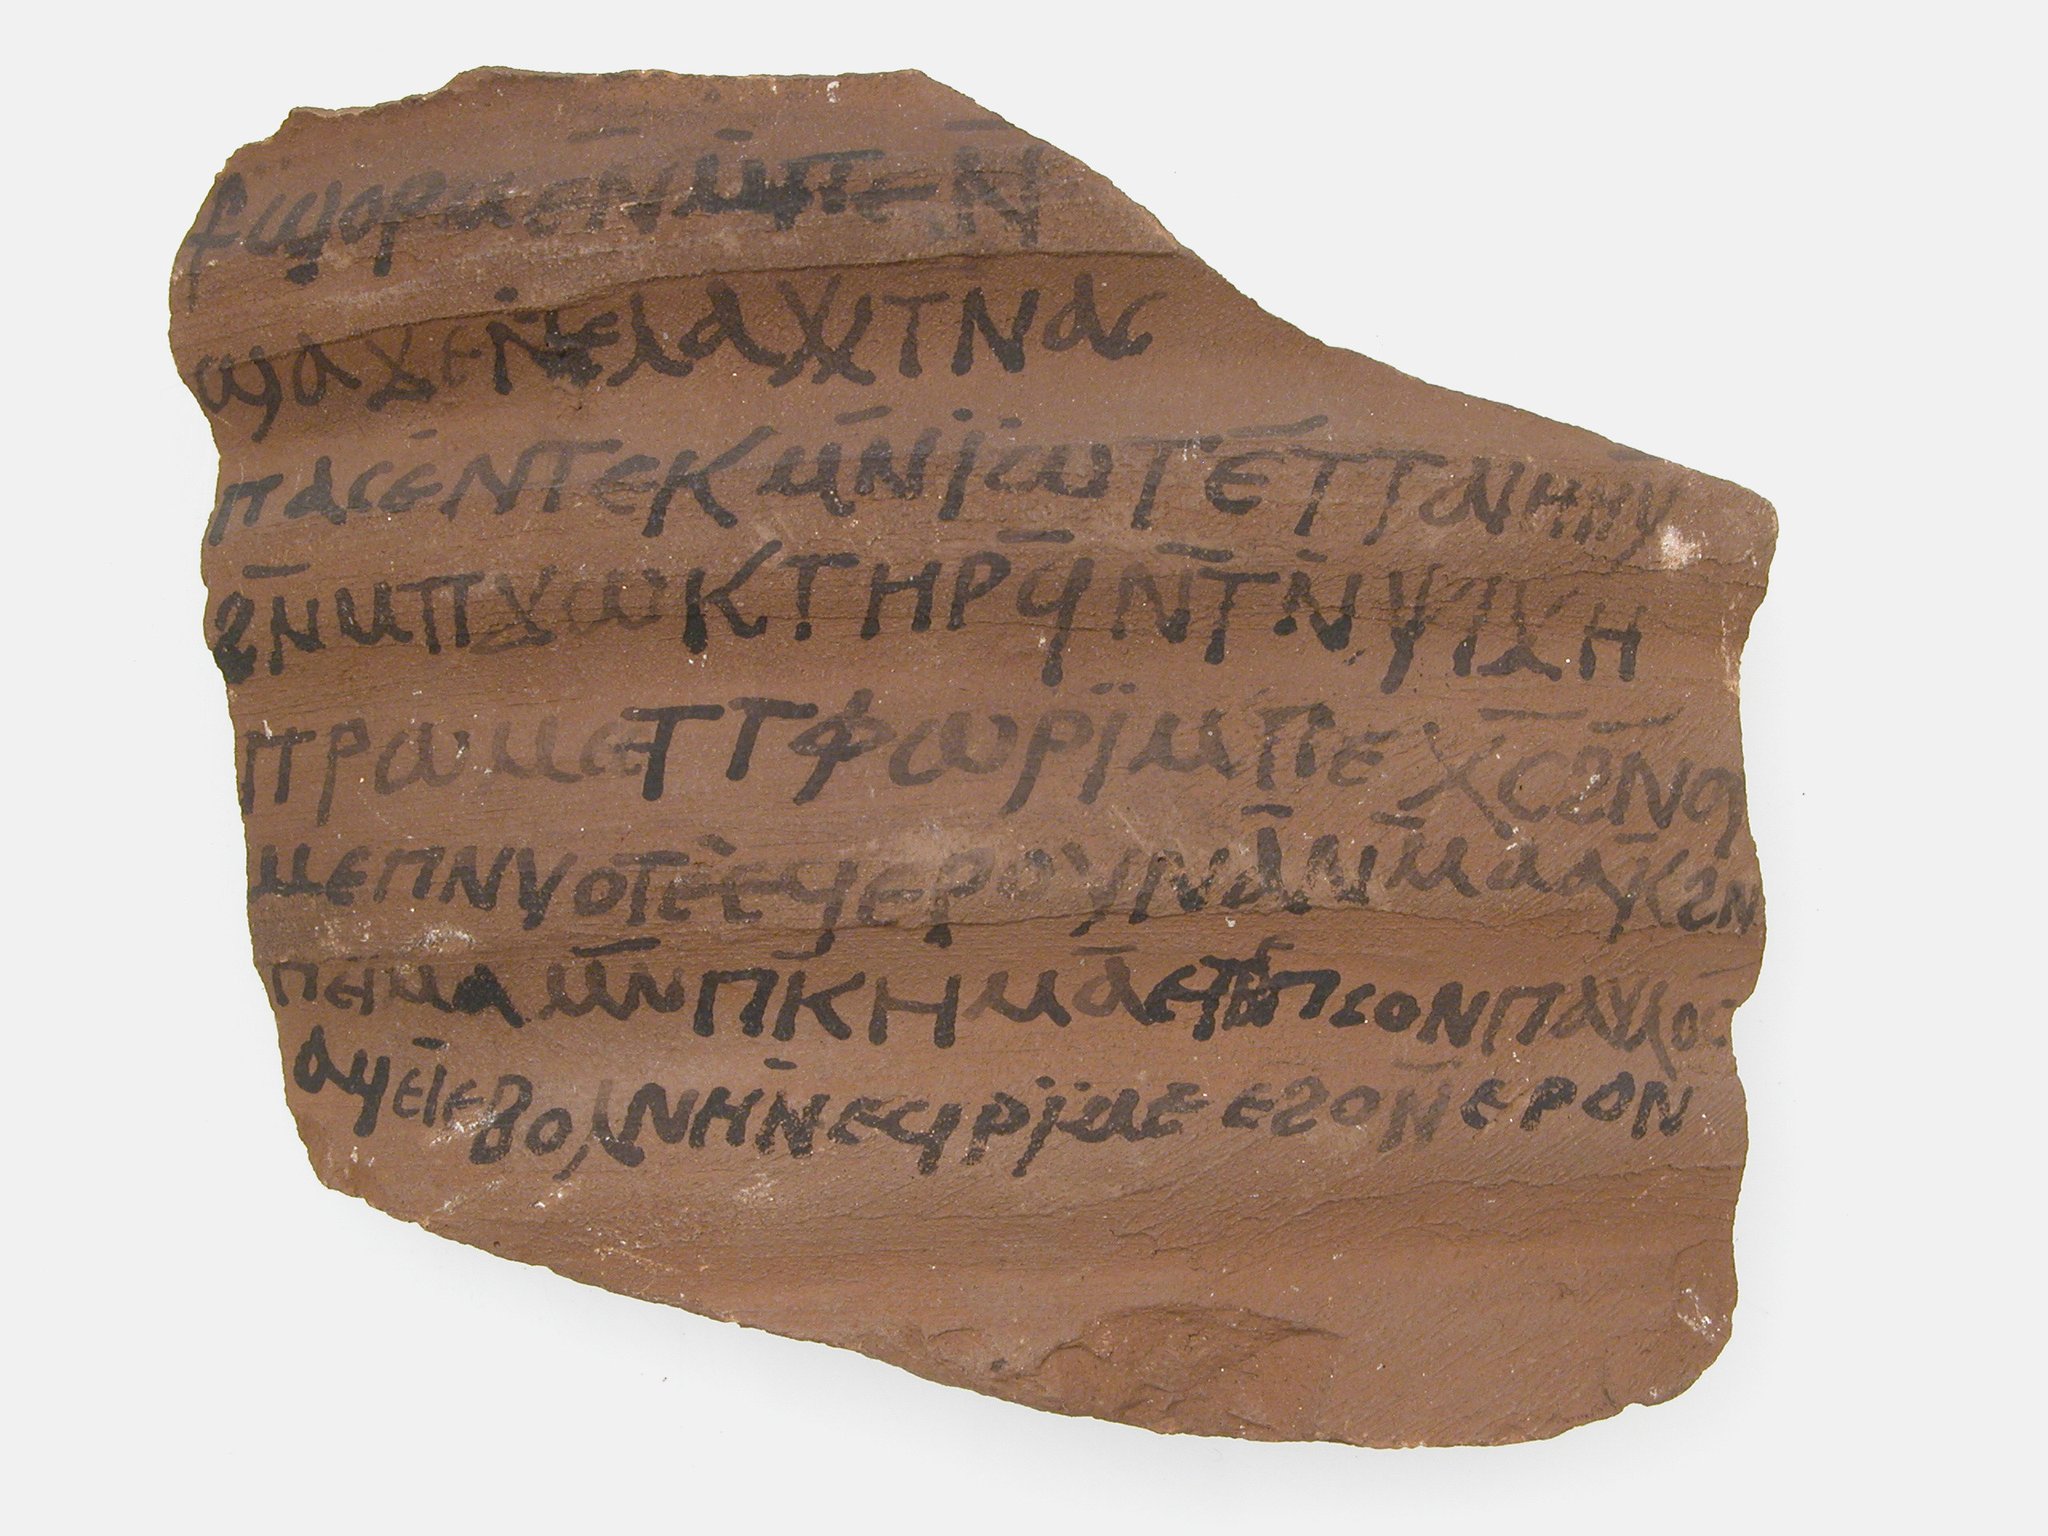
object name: ostrakon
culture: coptic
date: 601-700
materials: ink, pottery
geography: egypt